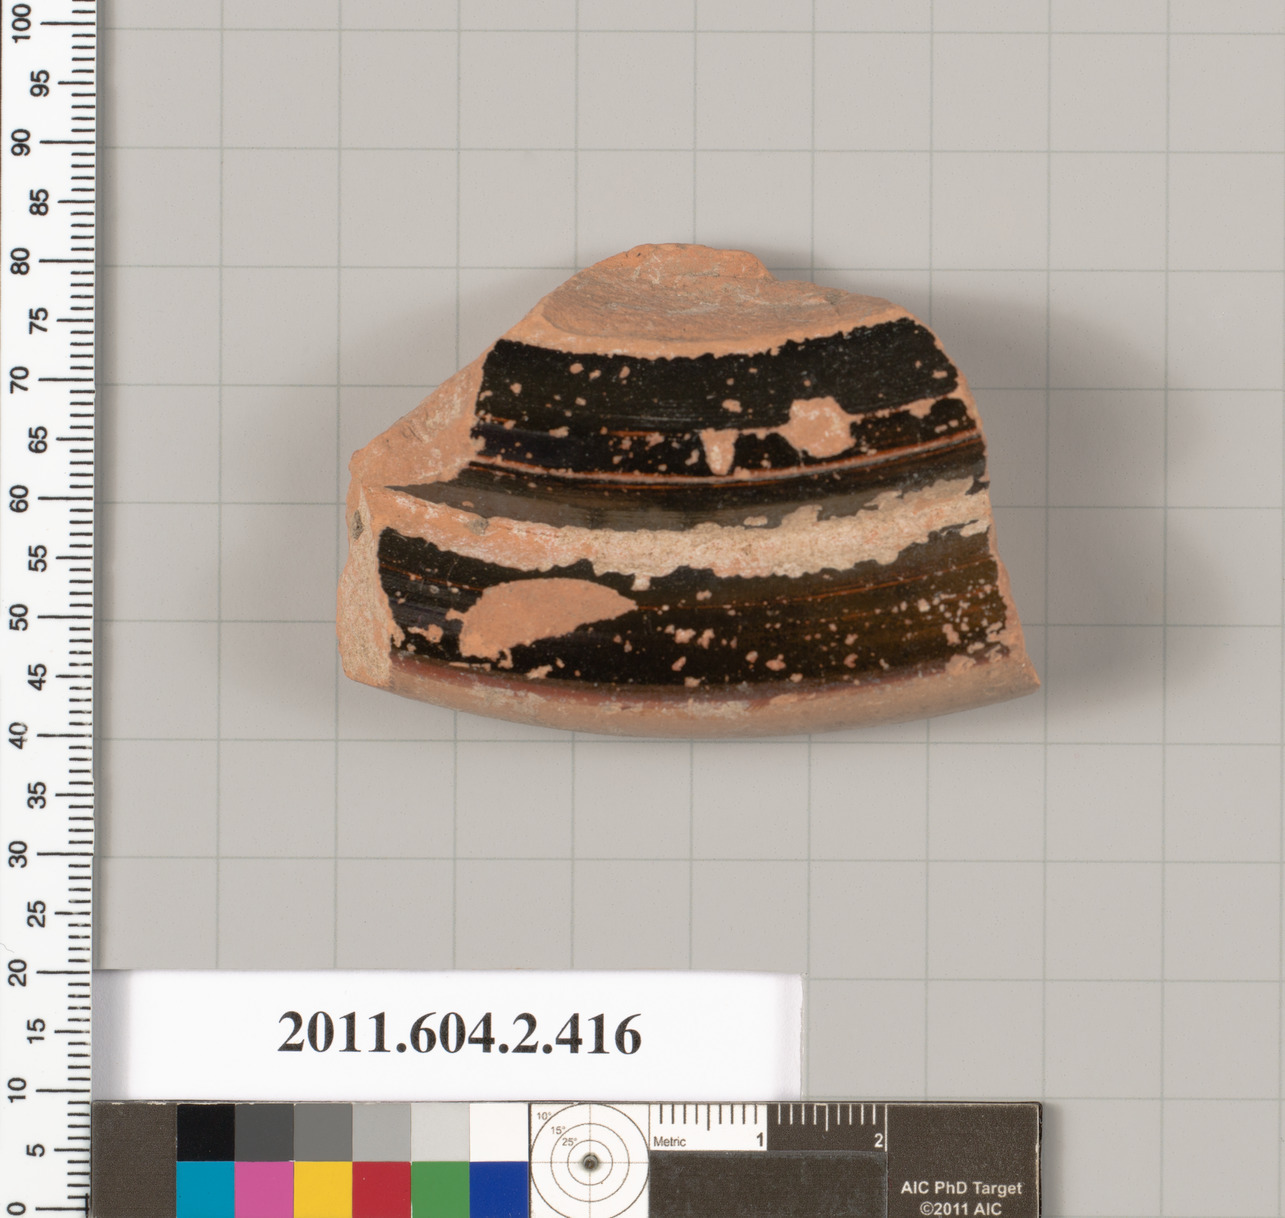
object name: column krater fragment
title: Terracotta fragment of a column-krater (bowl for mixing wine and water)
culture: greek, attic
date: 475-451 BCE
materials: terracotta